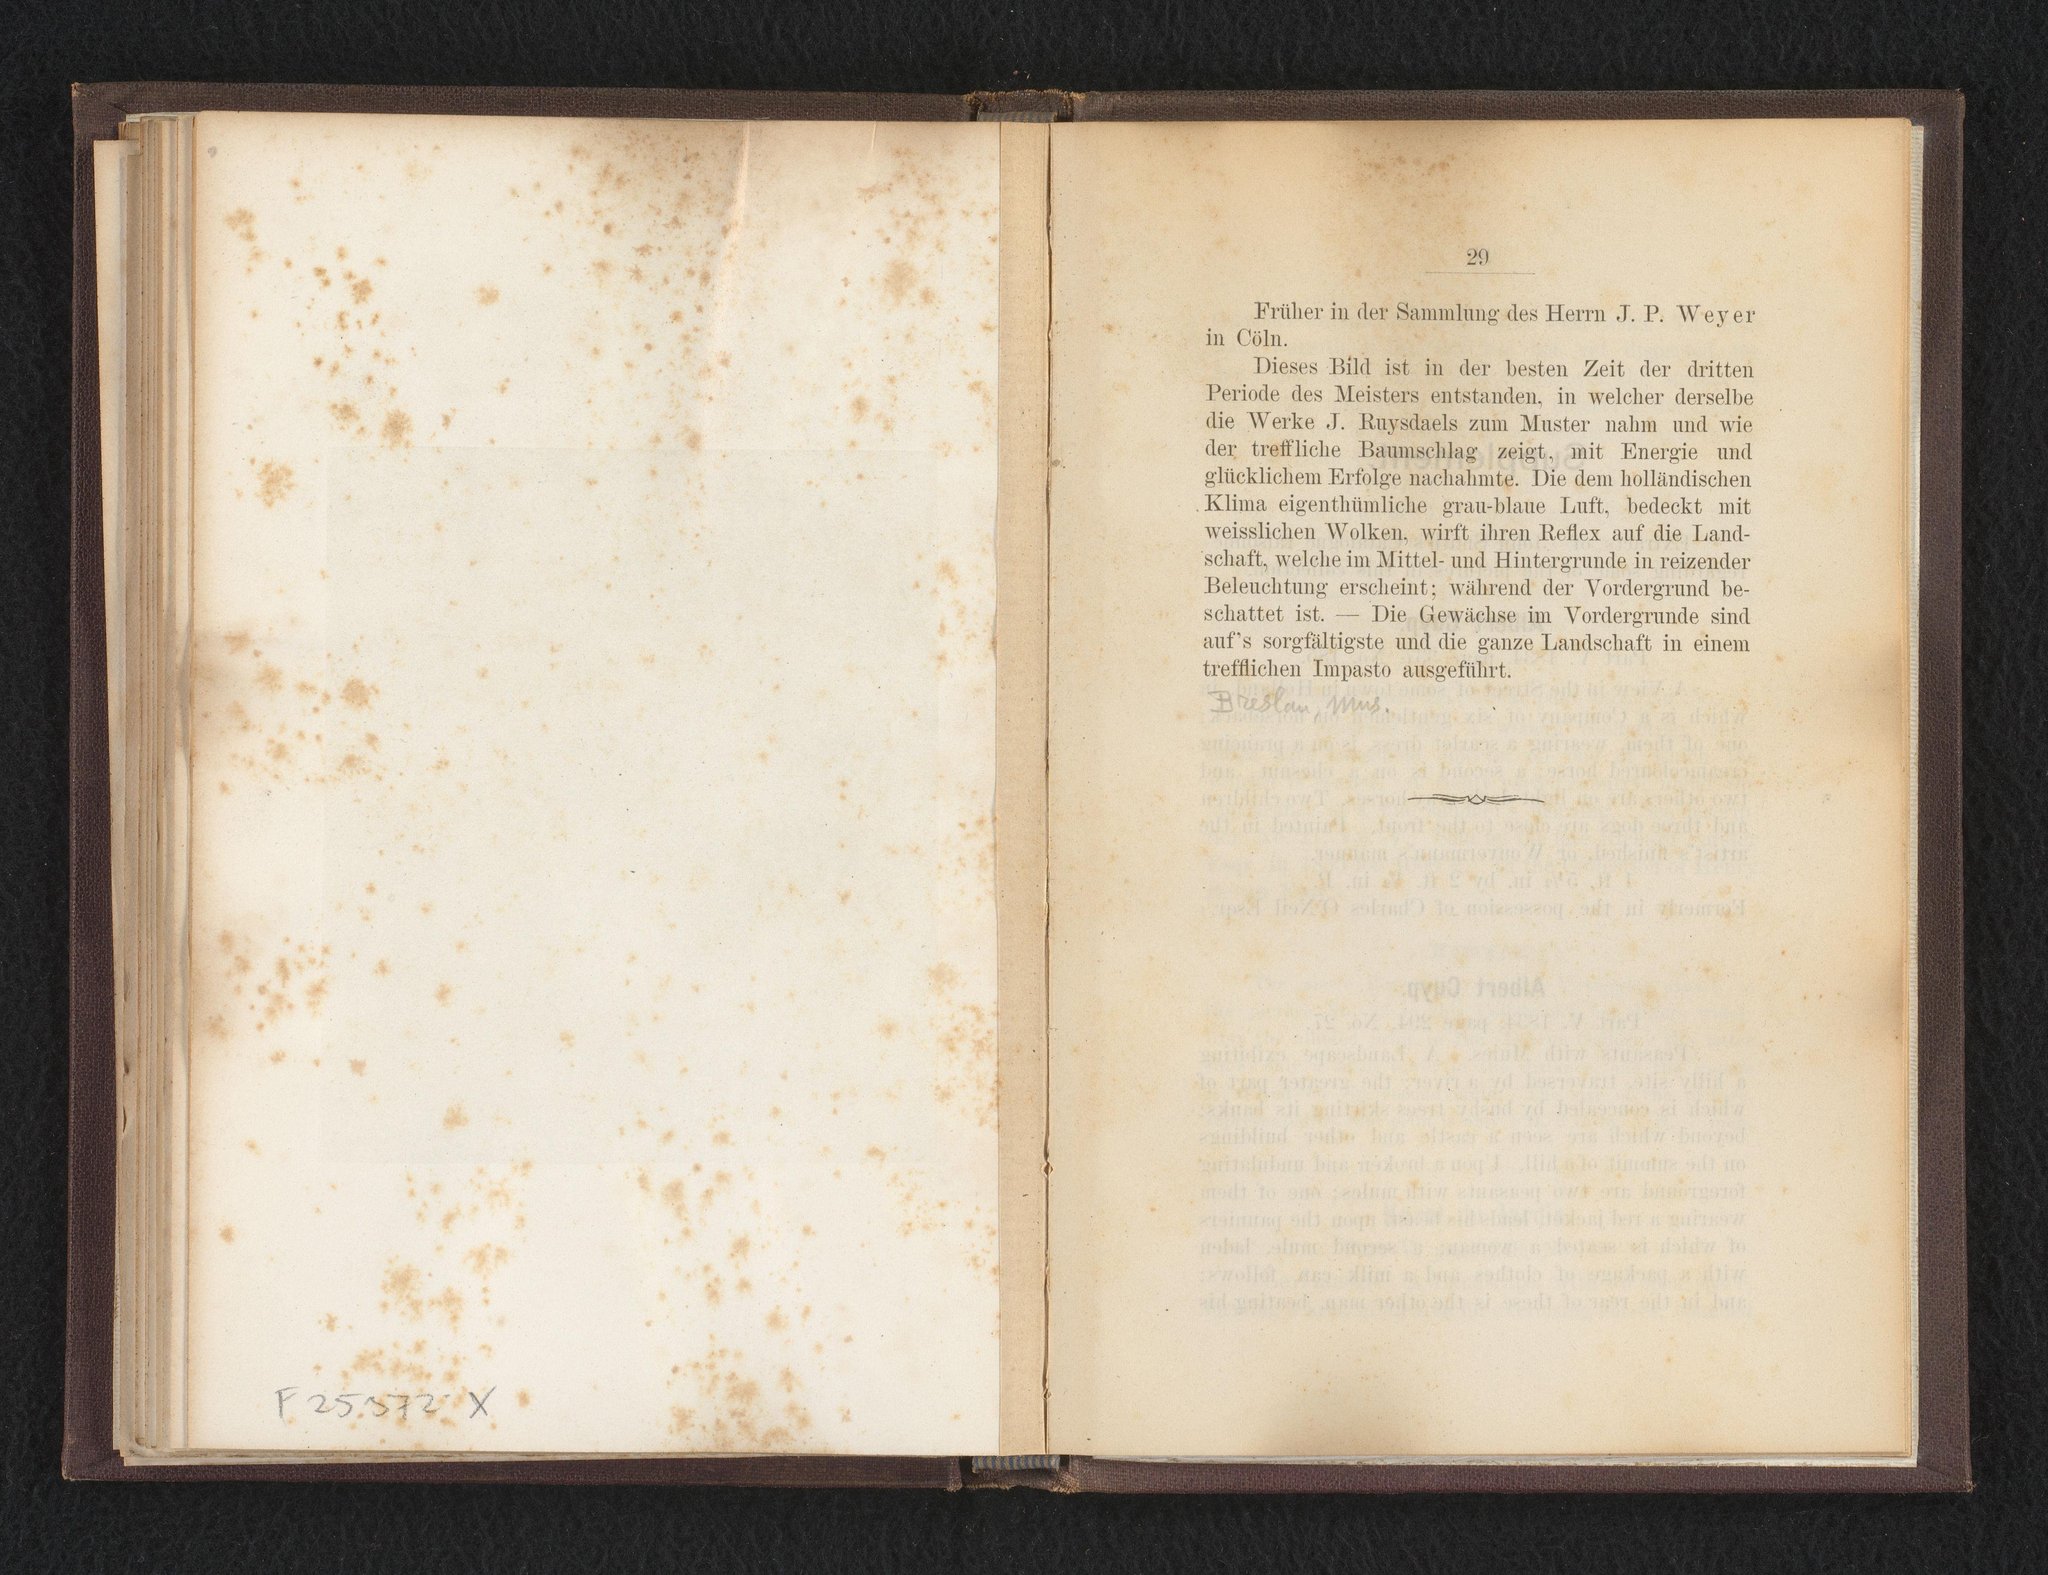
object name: page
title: Fotoreproductie van een schilderij van een gezelschap in een landschap door Jan Wijnants en Johannes Lingelbach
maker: julius hahn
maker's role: fotograaf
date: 1864-1874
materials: paper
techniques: albumen print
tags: picture, painting, landscapes (+ landscape with figures, staffage)